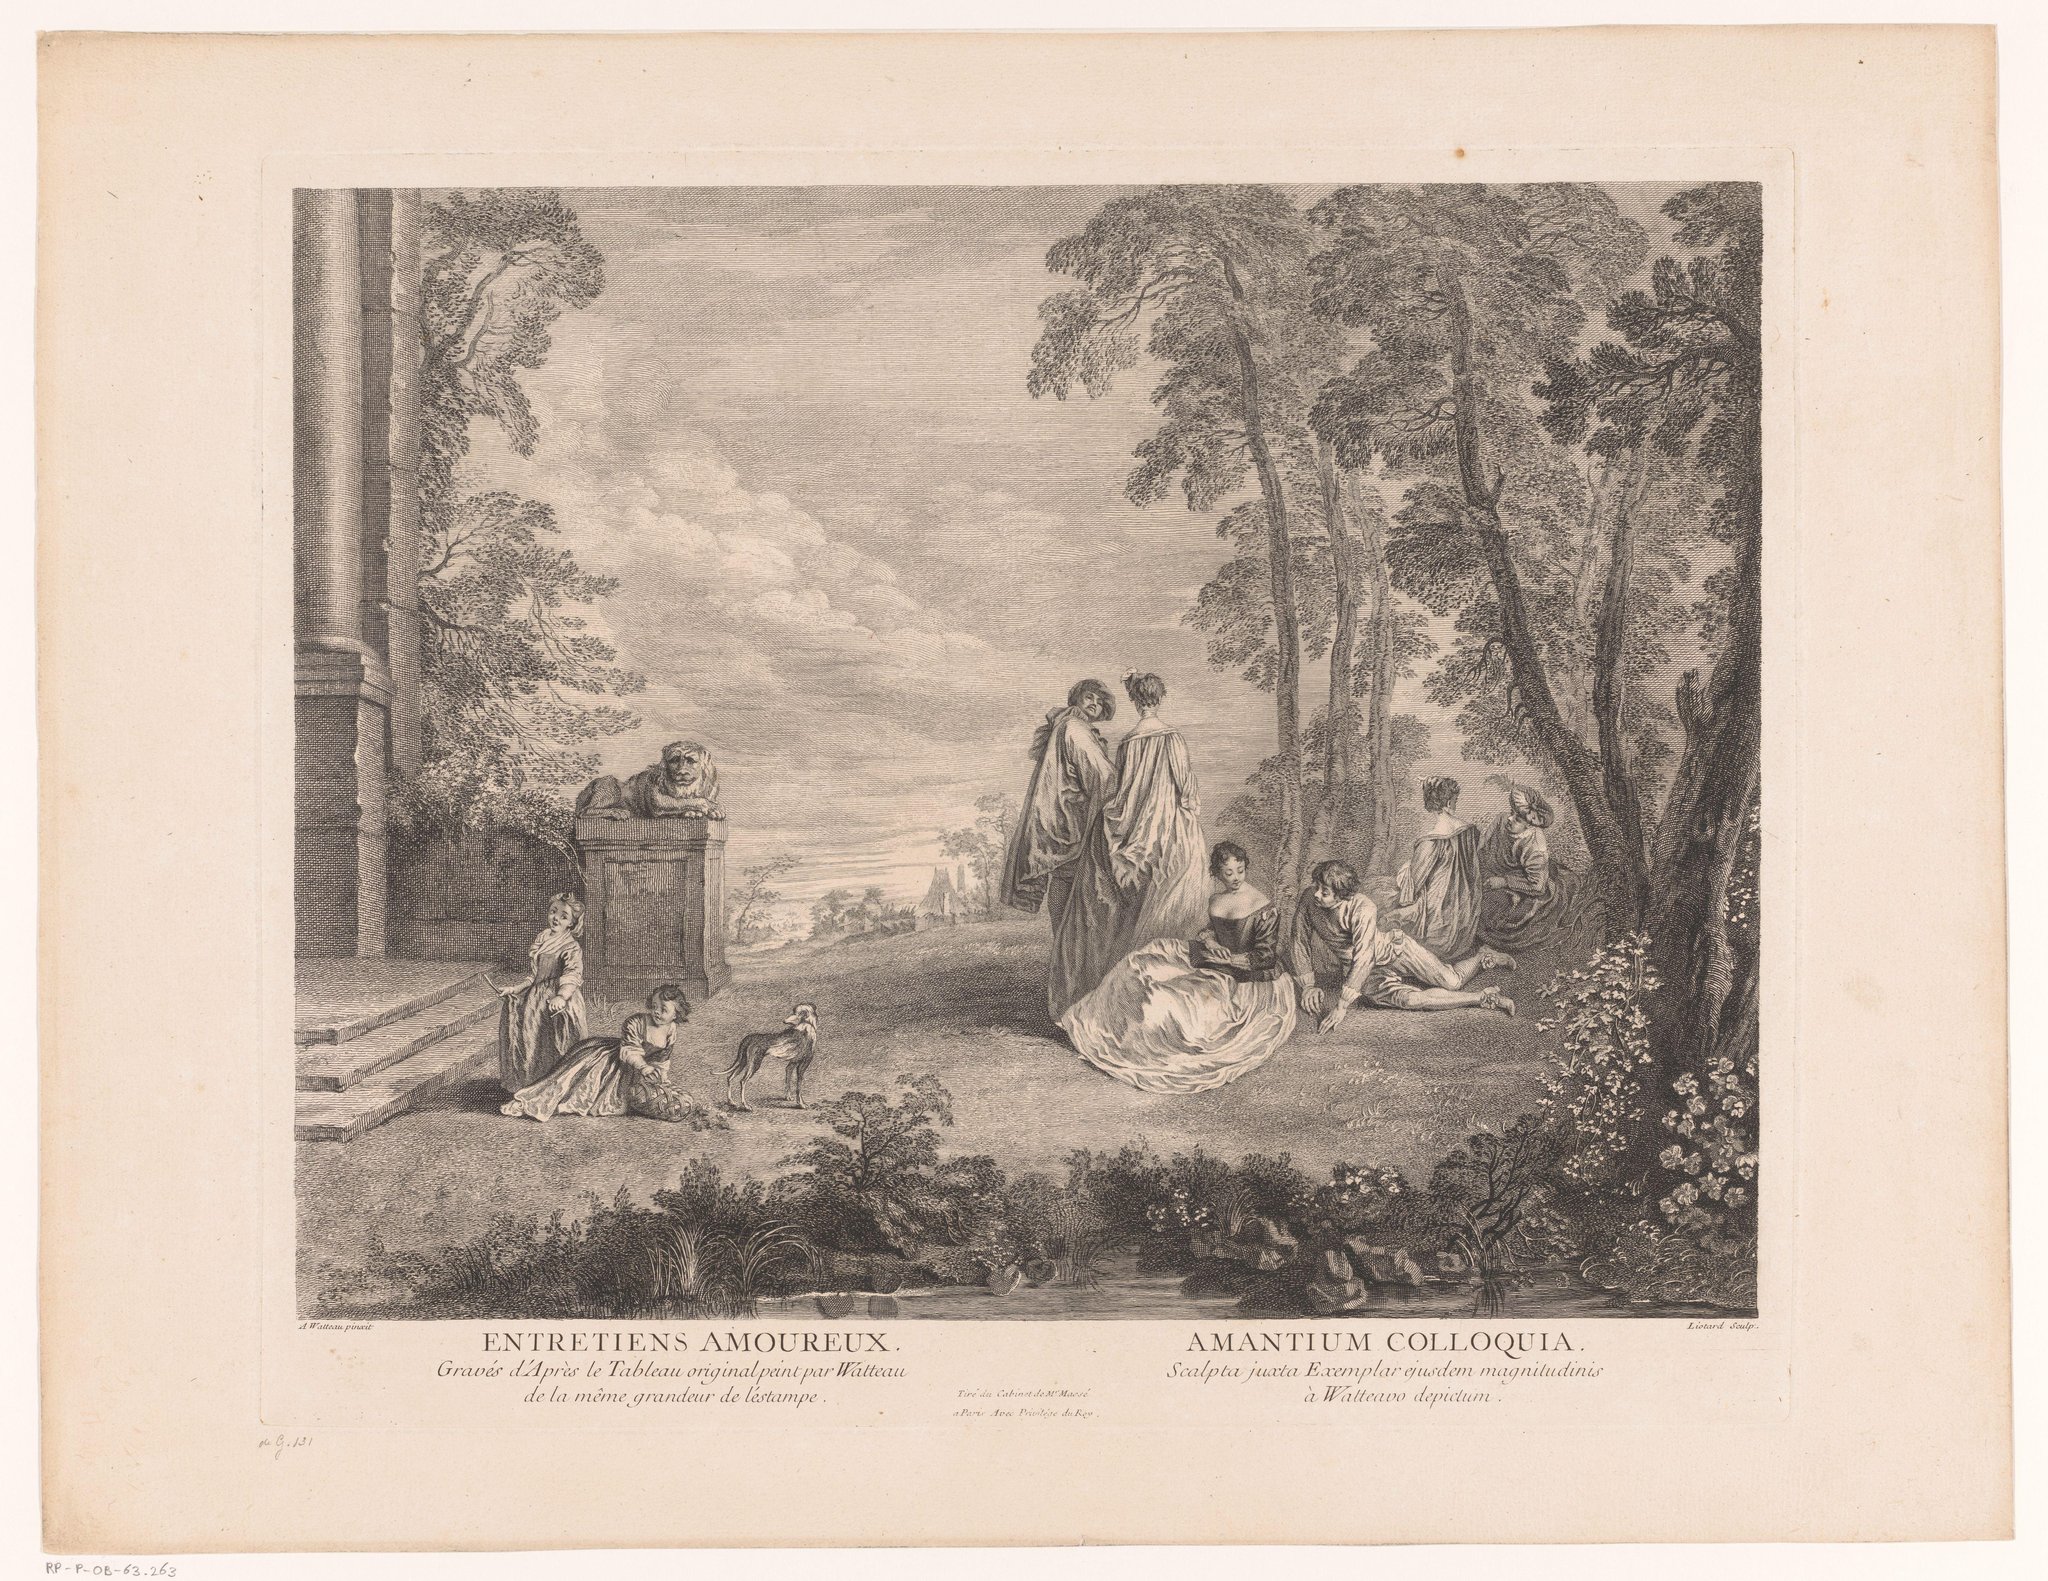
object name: print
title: Entretiens Amoureux / Amantium Colloquia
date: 1731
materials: paper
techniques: engraving, etching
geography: france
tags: garden, loggia, verandah, porch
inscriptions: collector's mark: Lugt 2228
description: Maakt deel uit van een serie van 271 platen naar schilderijen door Watteau, gecoördineerd door Jean de Jullienne en uitgegeven in Parijs tussen ca. 1726 en 1735. Sommige platen werden reeds tijdens Watteau's leven gemaakt. In 1735 werden honderd exemplaren van de voltooide serie uitgegeven. Dit betreft plaat 123 uit de serie.